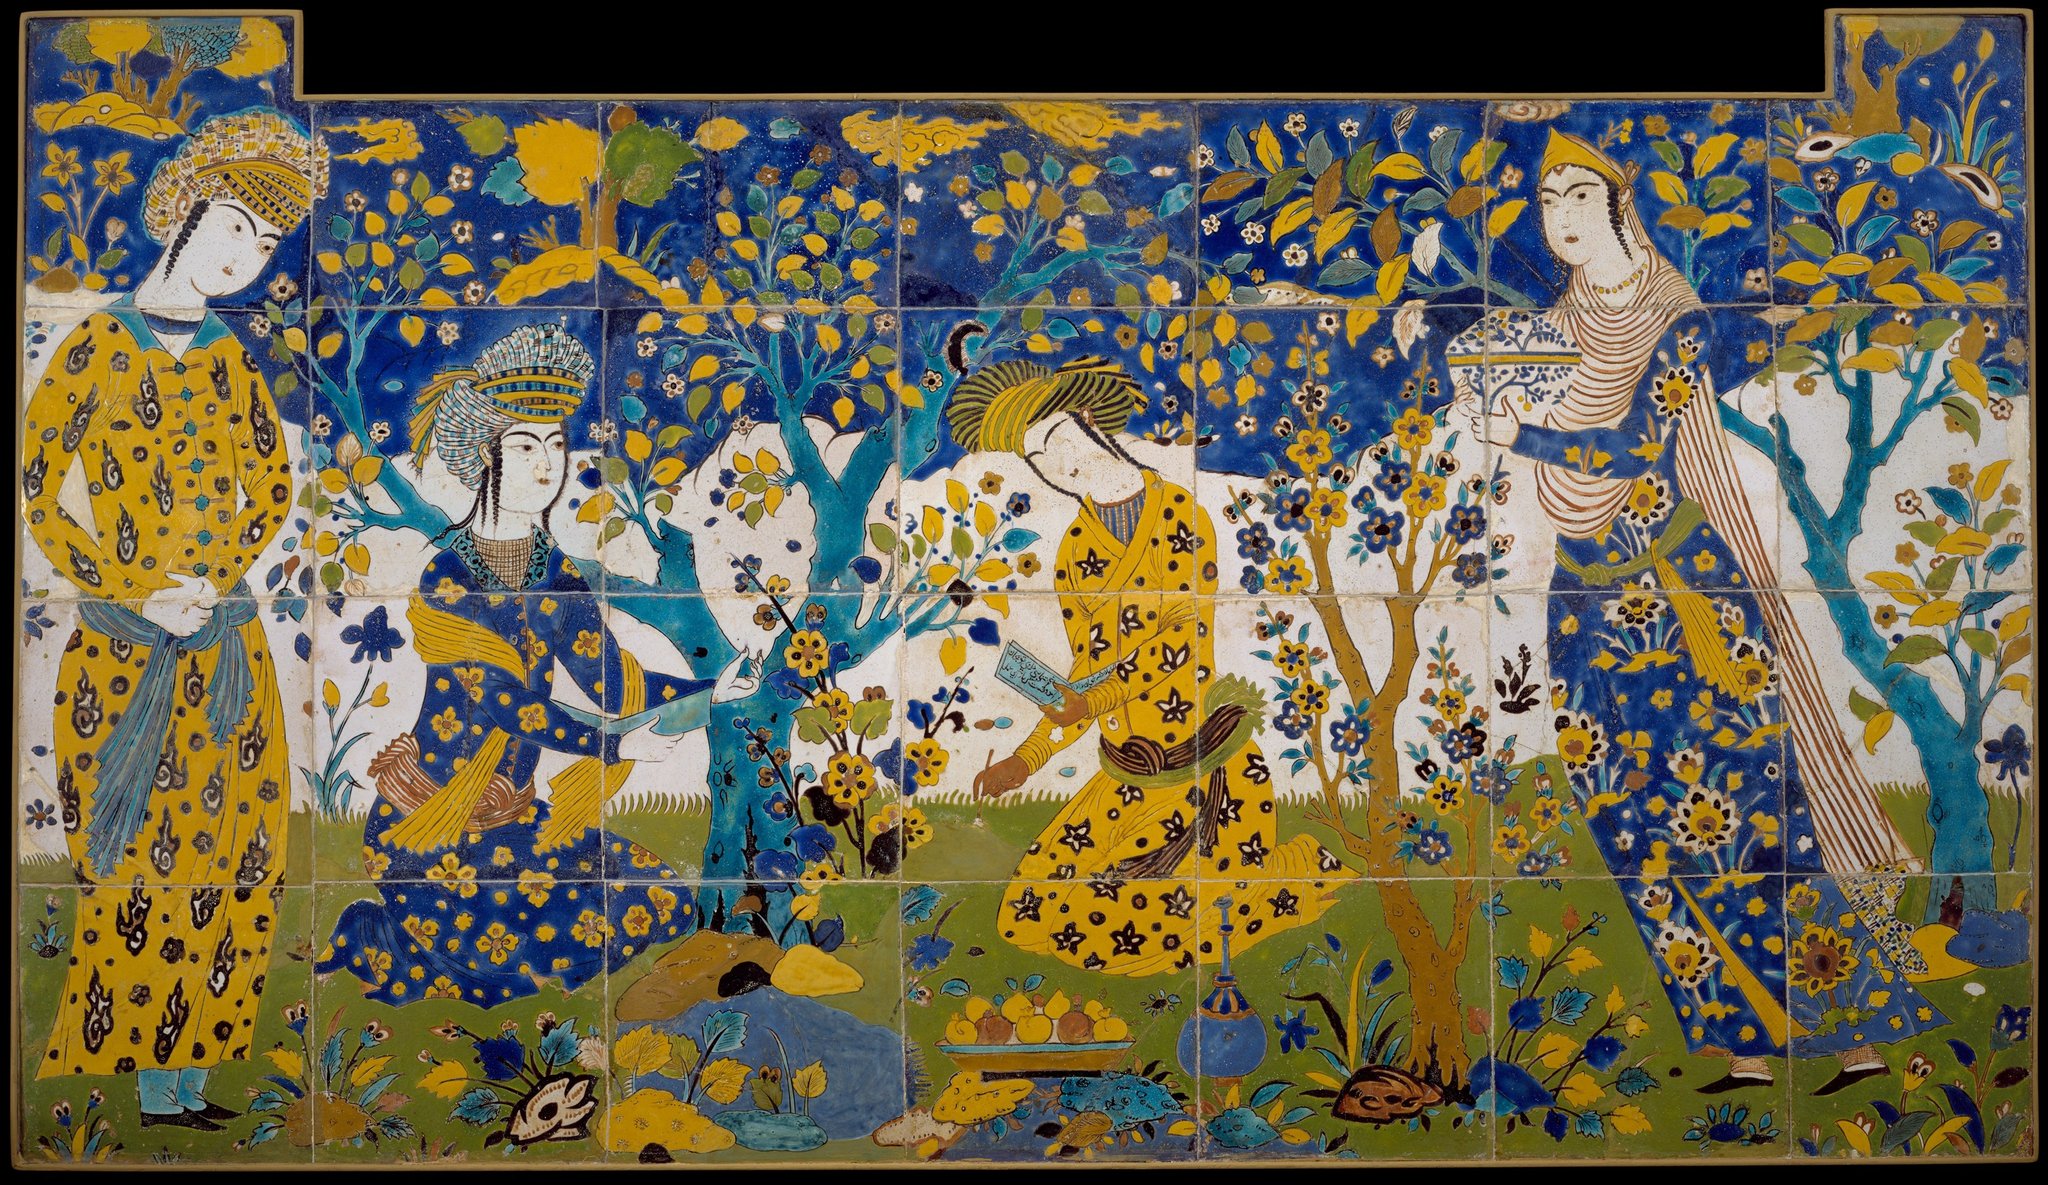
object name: tile panel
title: Reciting Poetry in a Garden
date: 1601-1625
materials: glaze, stonepaste, wax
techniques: polychrome, resist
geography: iran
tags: gardens,men,women,flowers,trees